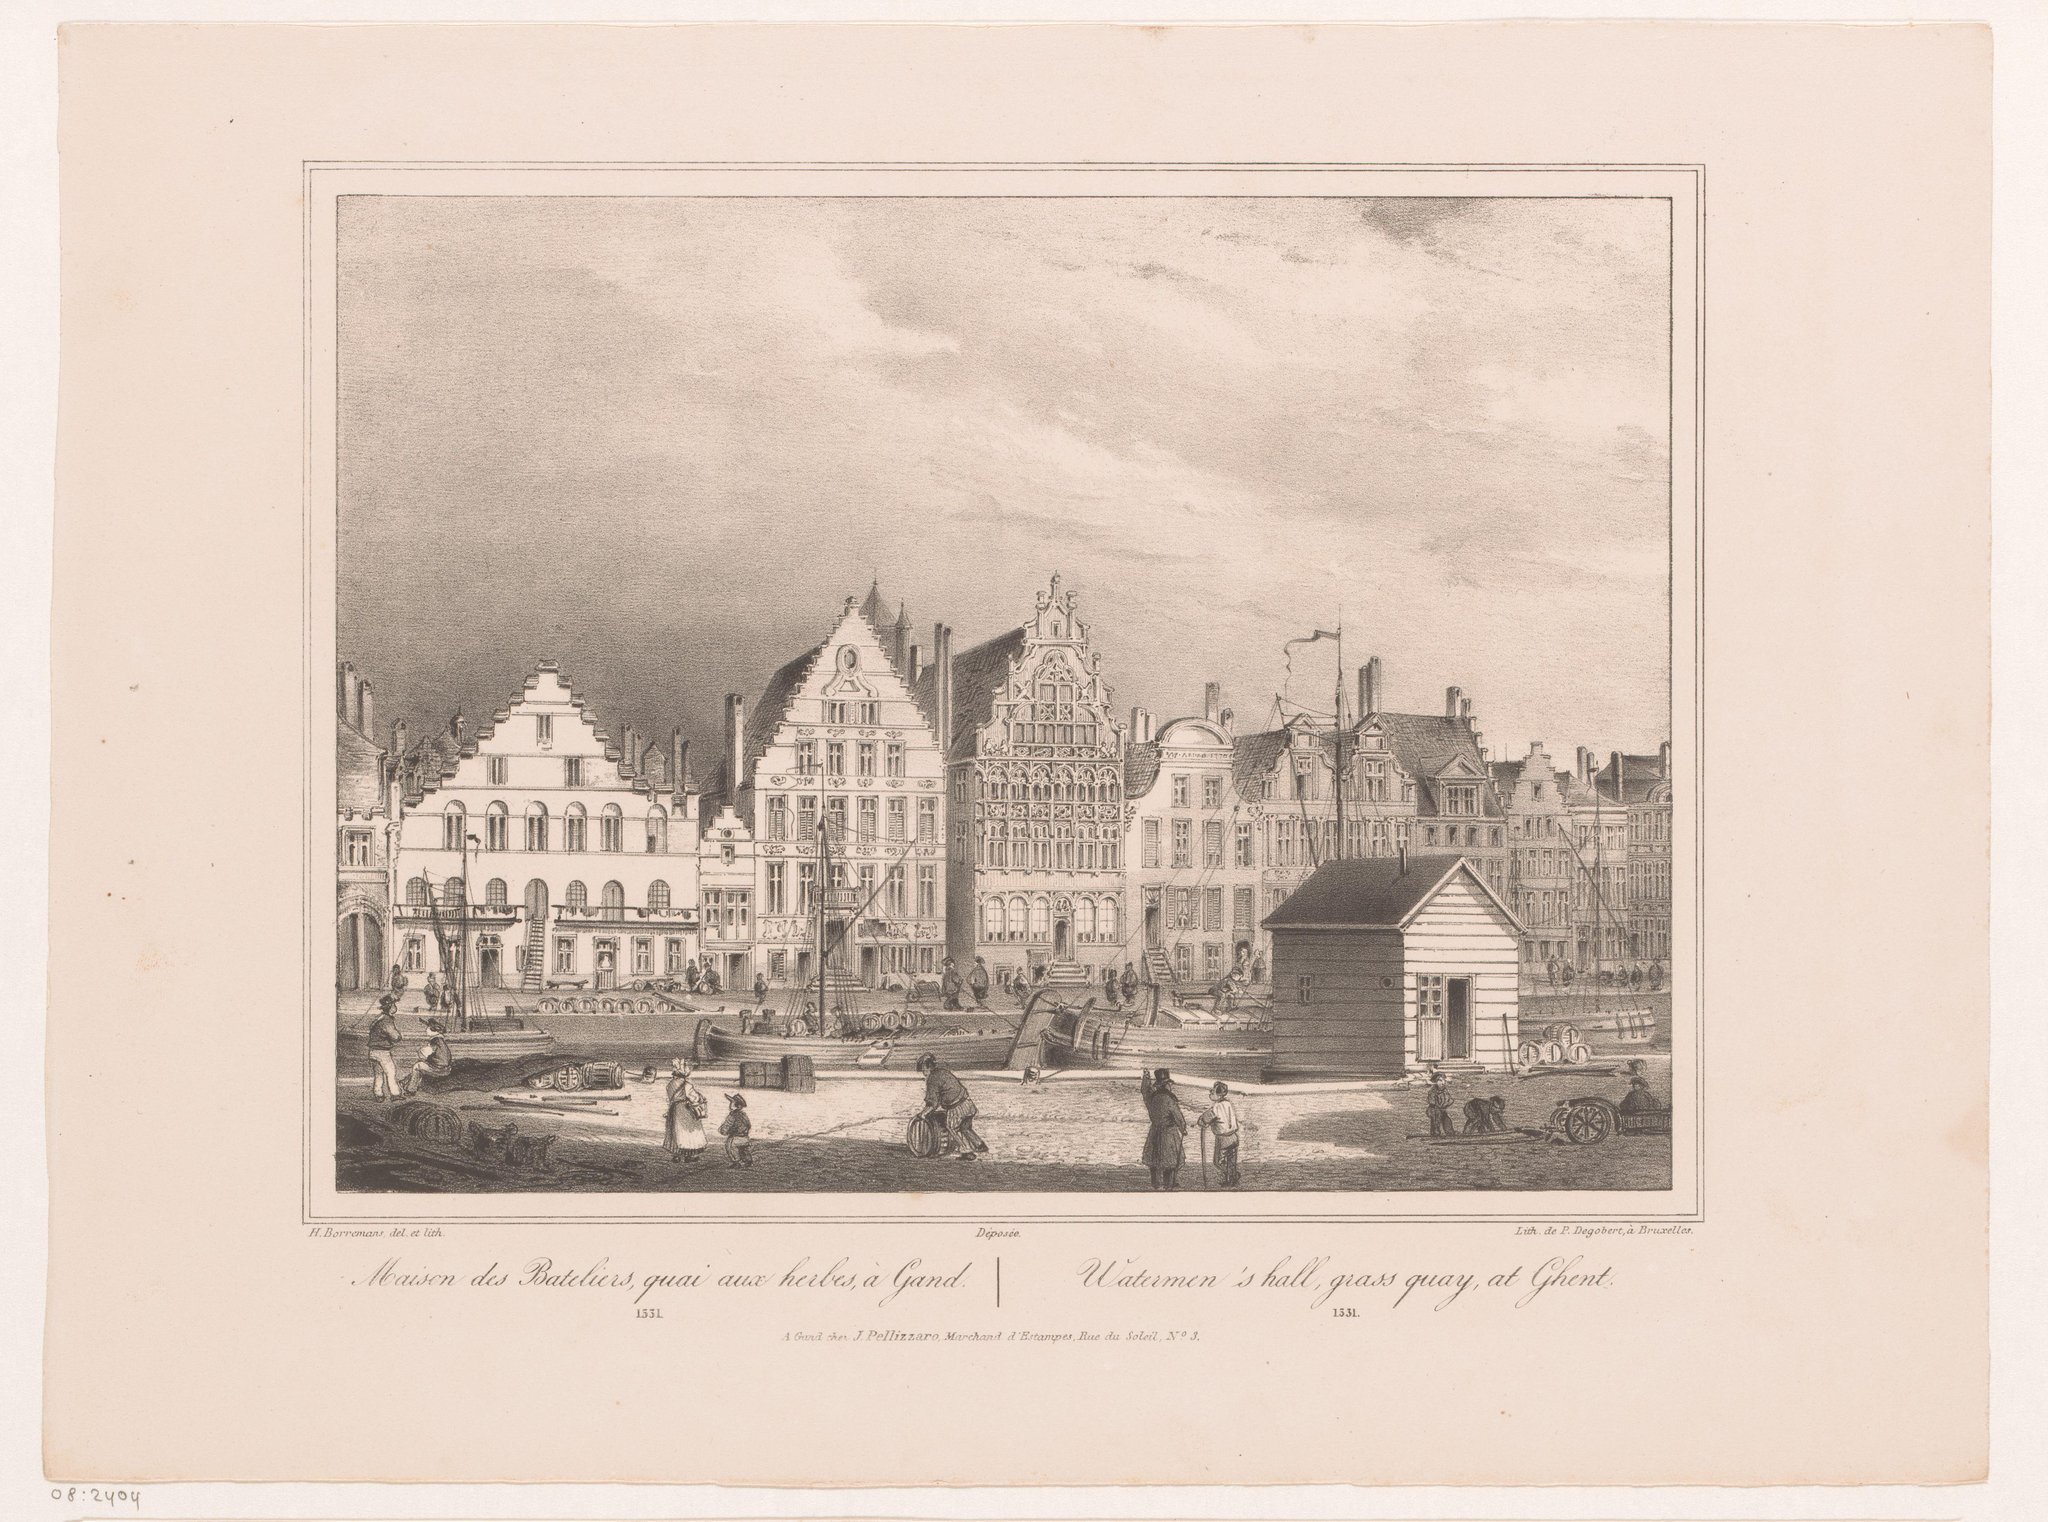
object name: print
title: Album des monumens de Gand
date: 1822-1844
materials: paper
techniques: lithograph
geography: ghent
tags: harbour, quay (+ city(-scape) with figures, staffage), ghent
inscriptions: collector's mark: Lugt 2228, : ‘Déposé’